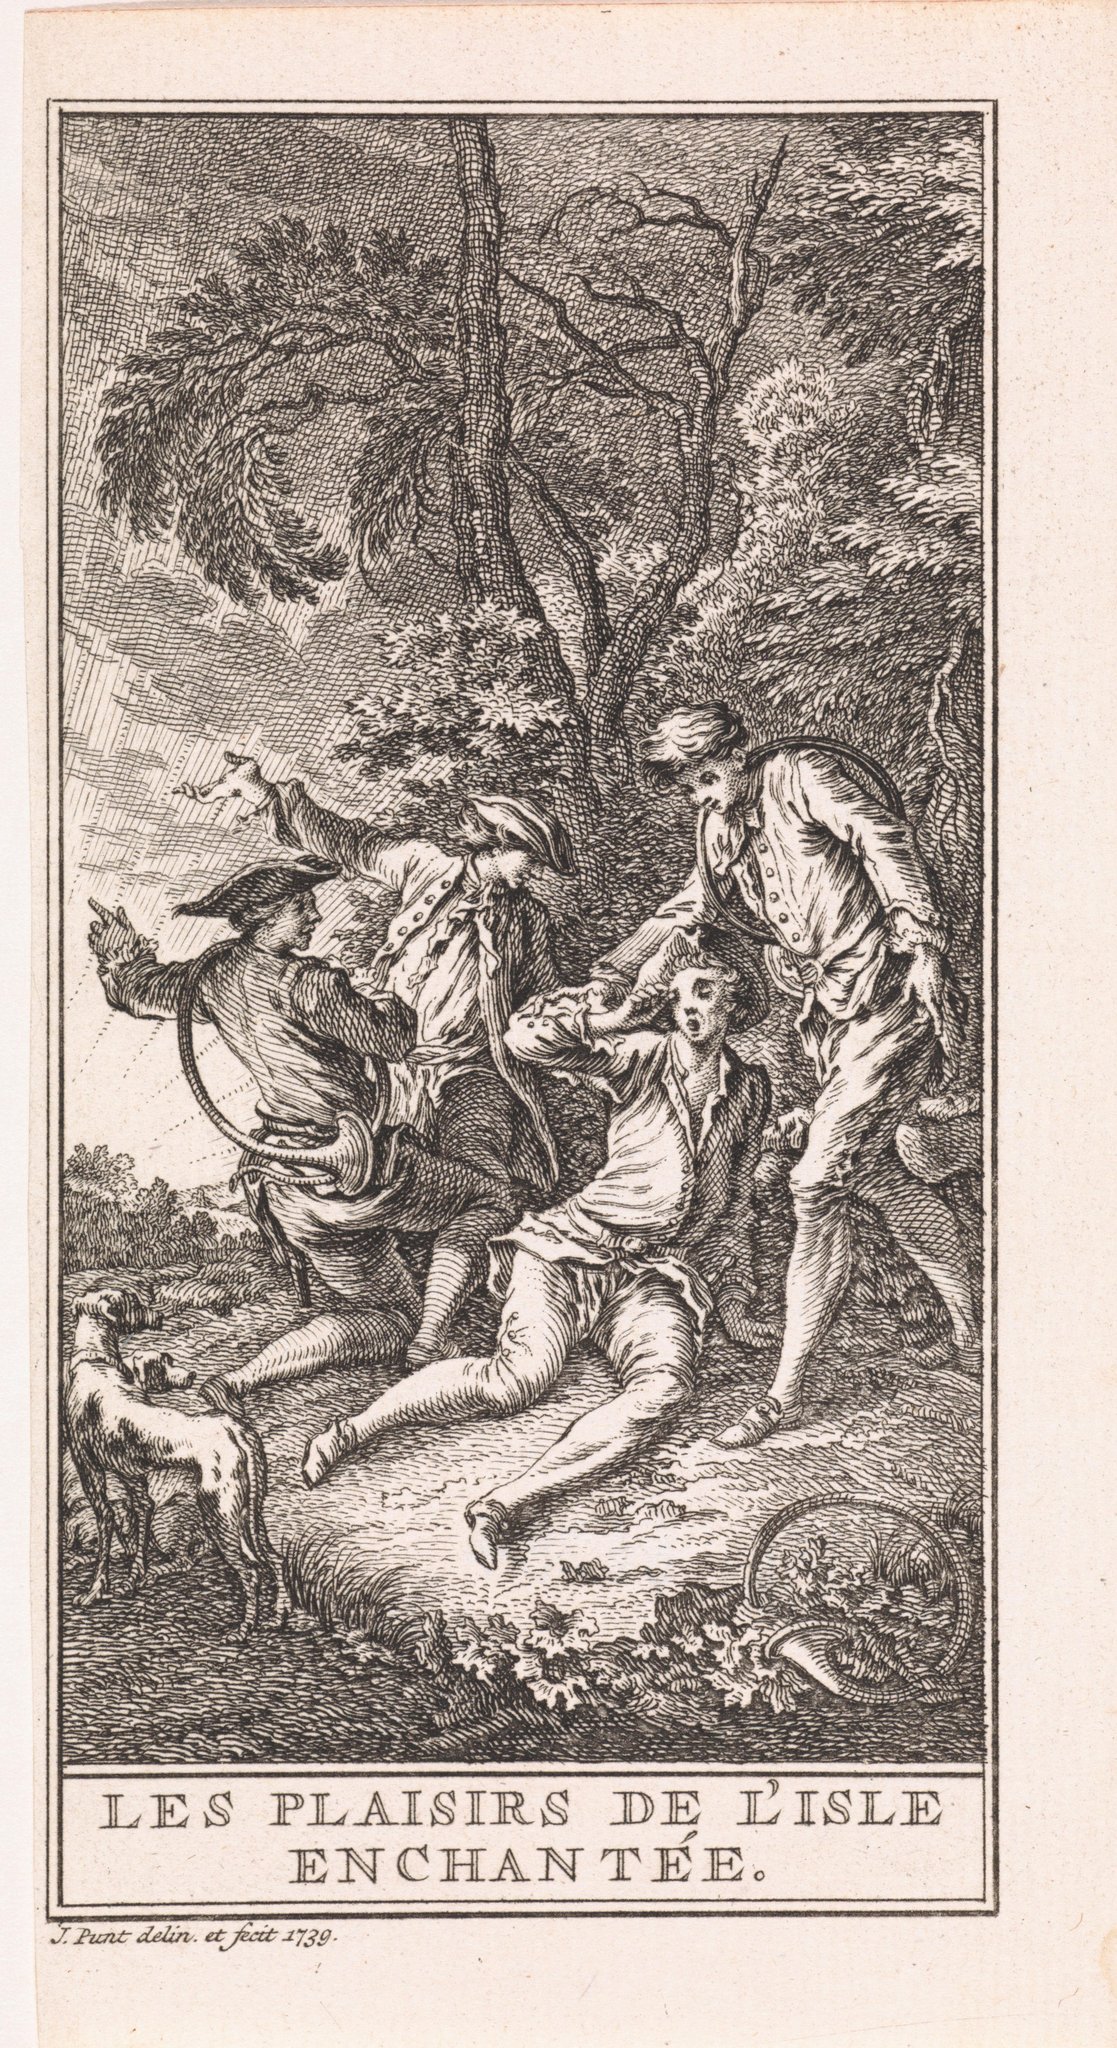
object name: print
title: Les Plaisirs de L'Isle Enchantée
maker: jan punt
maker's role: draughtsman, print maker, publisher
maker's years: 1711-1779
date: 1739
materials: paper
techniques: engraving, etching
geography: amsterdam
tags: (moliere) specific works of literature (with author, title), hunter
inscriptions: collector's mark: Lugt 2228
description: Een jonge man zit bedroefd op de grond tijdens de jacht. Drie mannen wijzen hem ergens op. Jachthonden en een jachthoorn op de voorgrond. Scène uit het verslag van Molière van Les fêtes des Plaisirs de l’Ile Enchantée, het feest gehouden te Versailles in mei 1664.